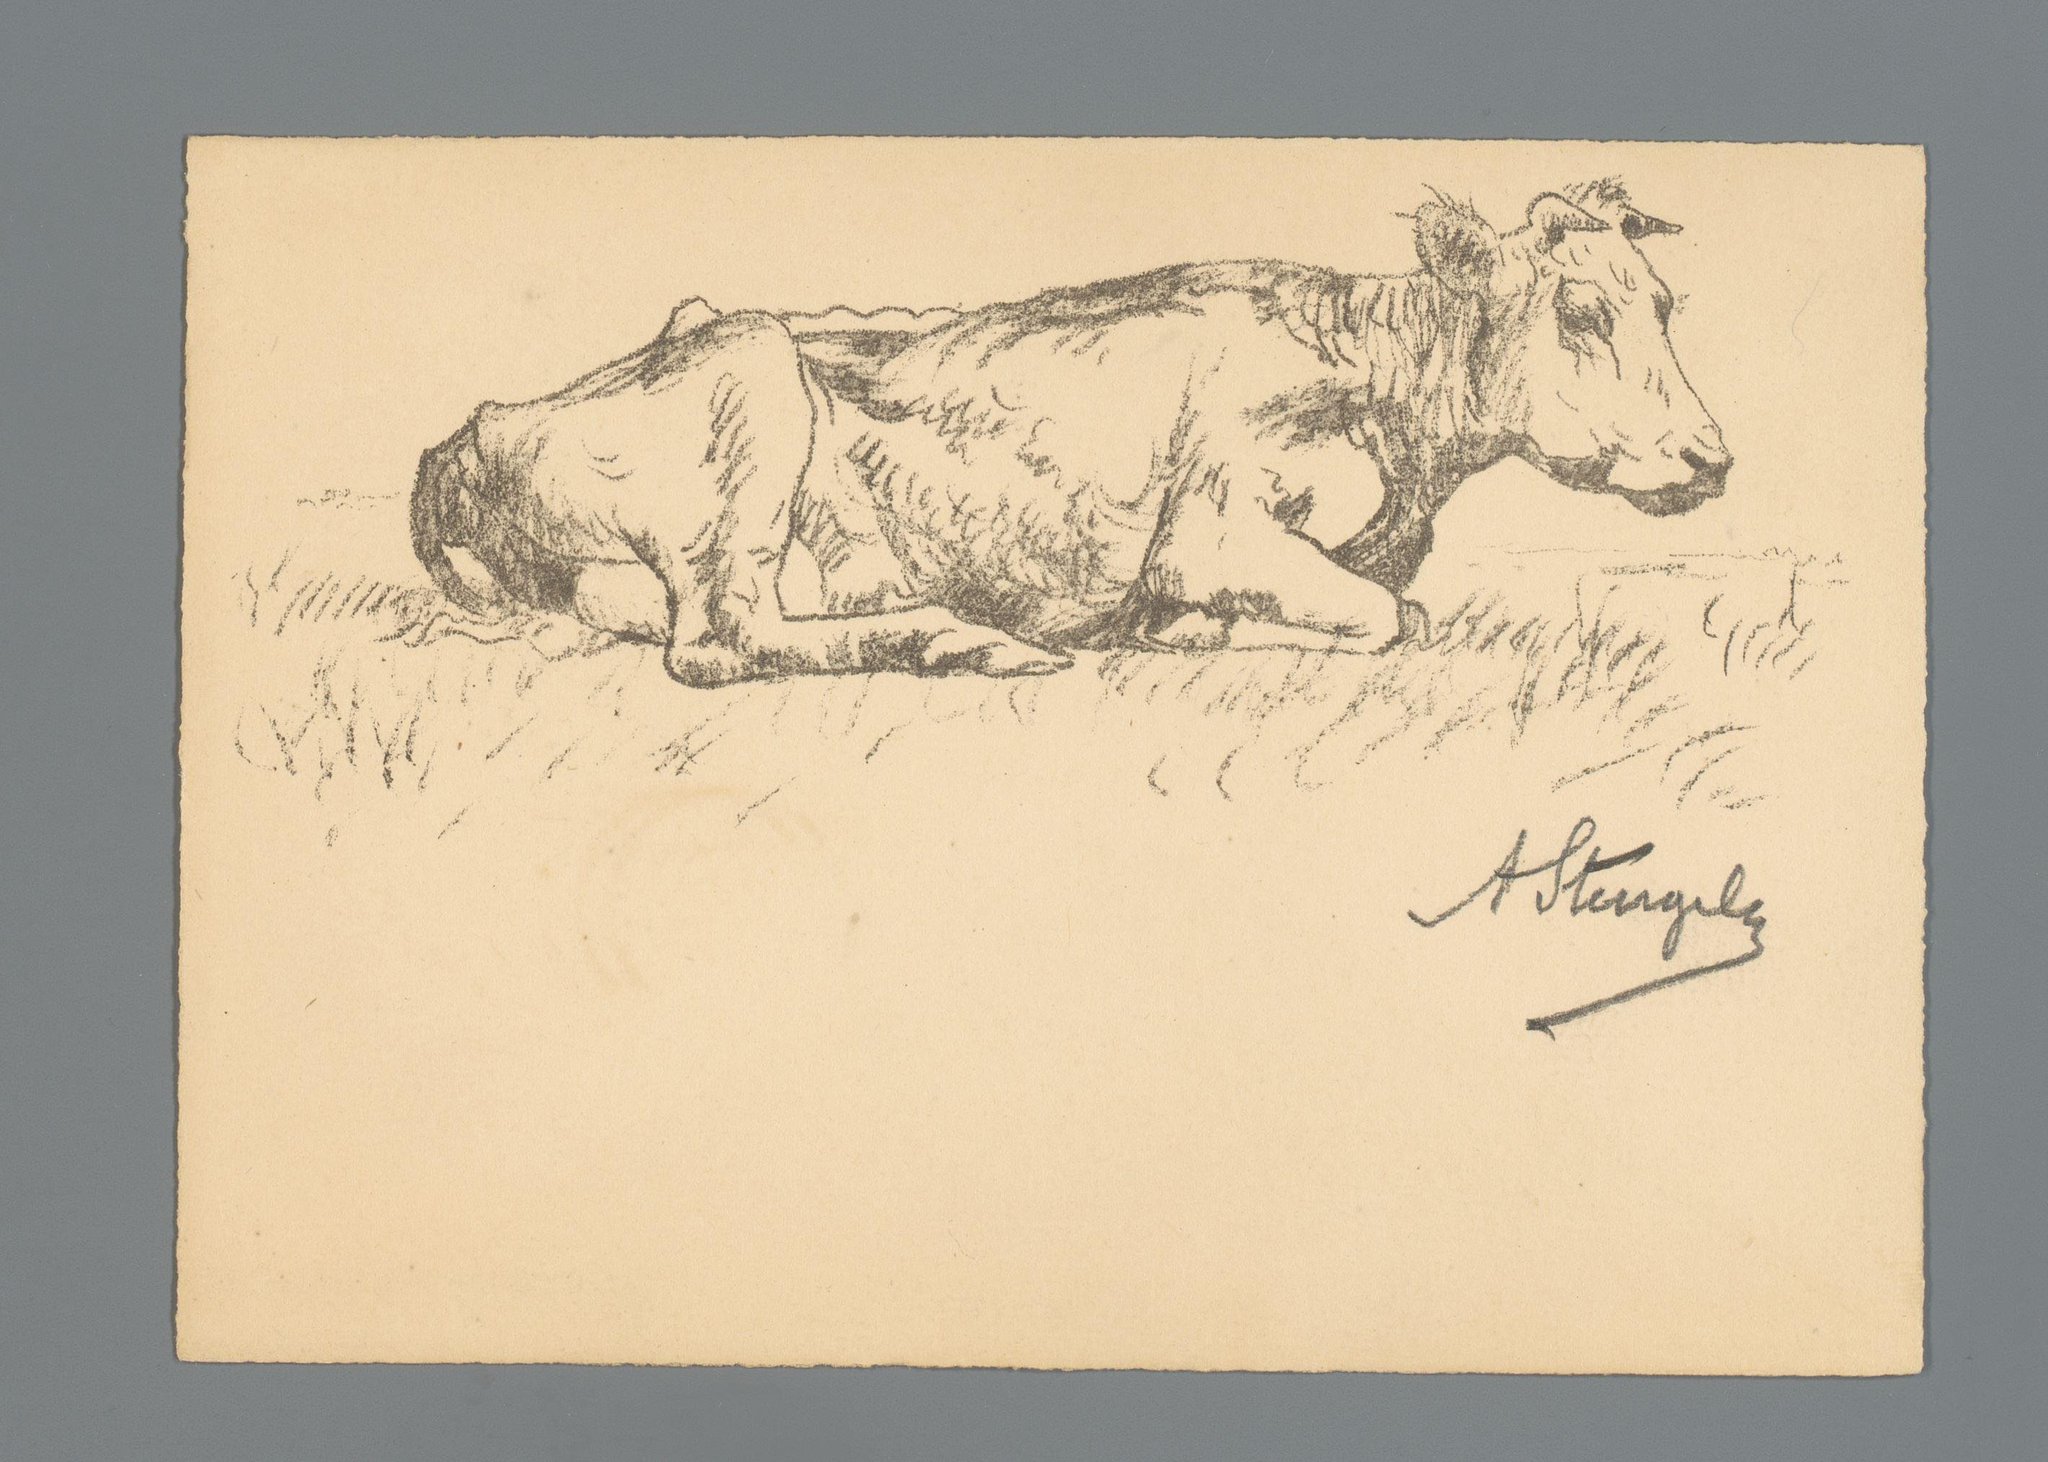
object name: print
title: Liggende koe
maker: alphonse stengelin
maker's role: painter, print maker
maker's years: 1852-1938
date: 1862-1910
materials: paper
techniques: lithograph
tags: cow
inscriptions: inscription: ‘A. Stengelin/ Ecully/ Rhône’